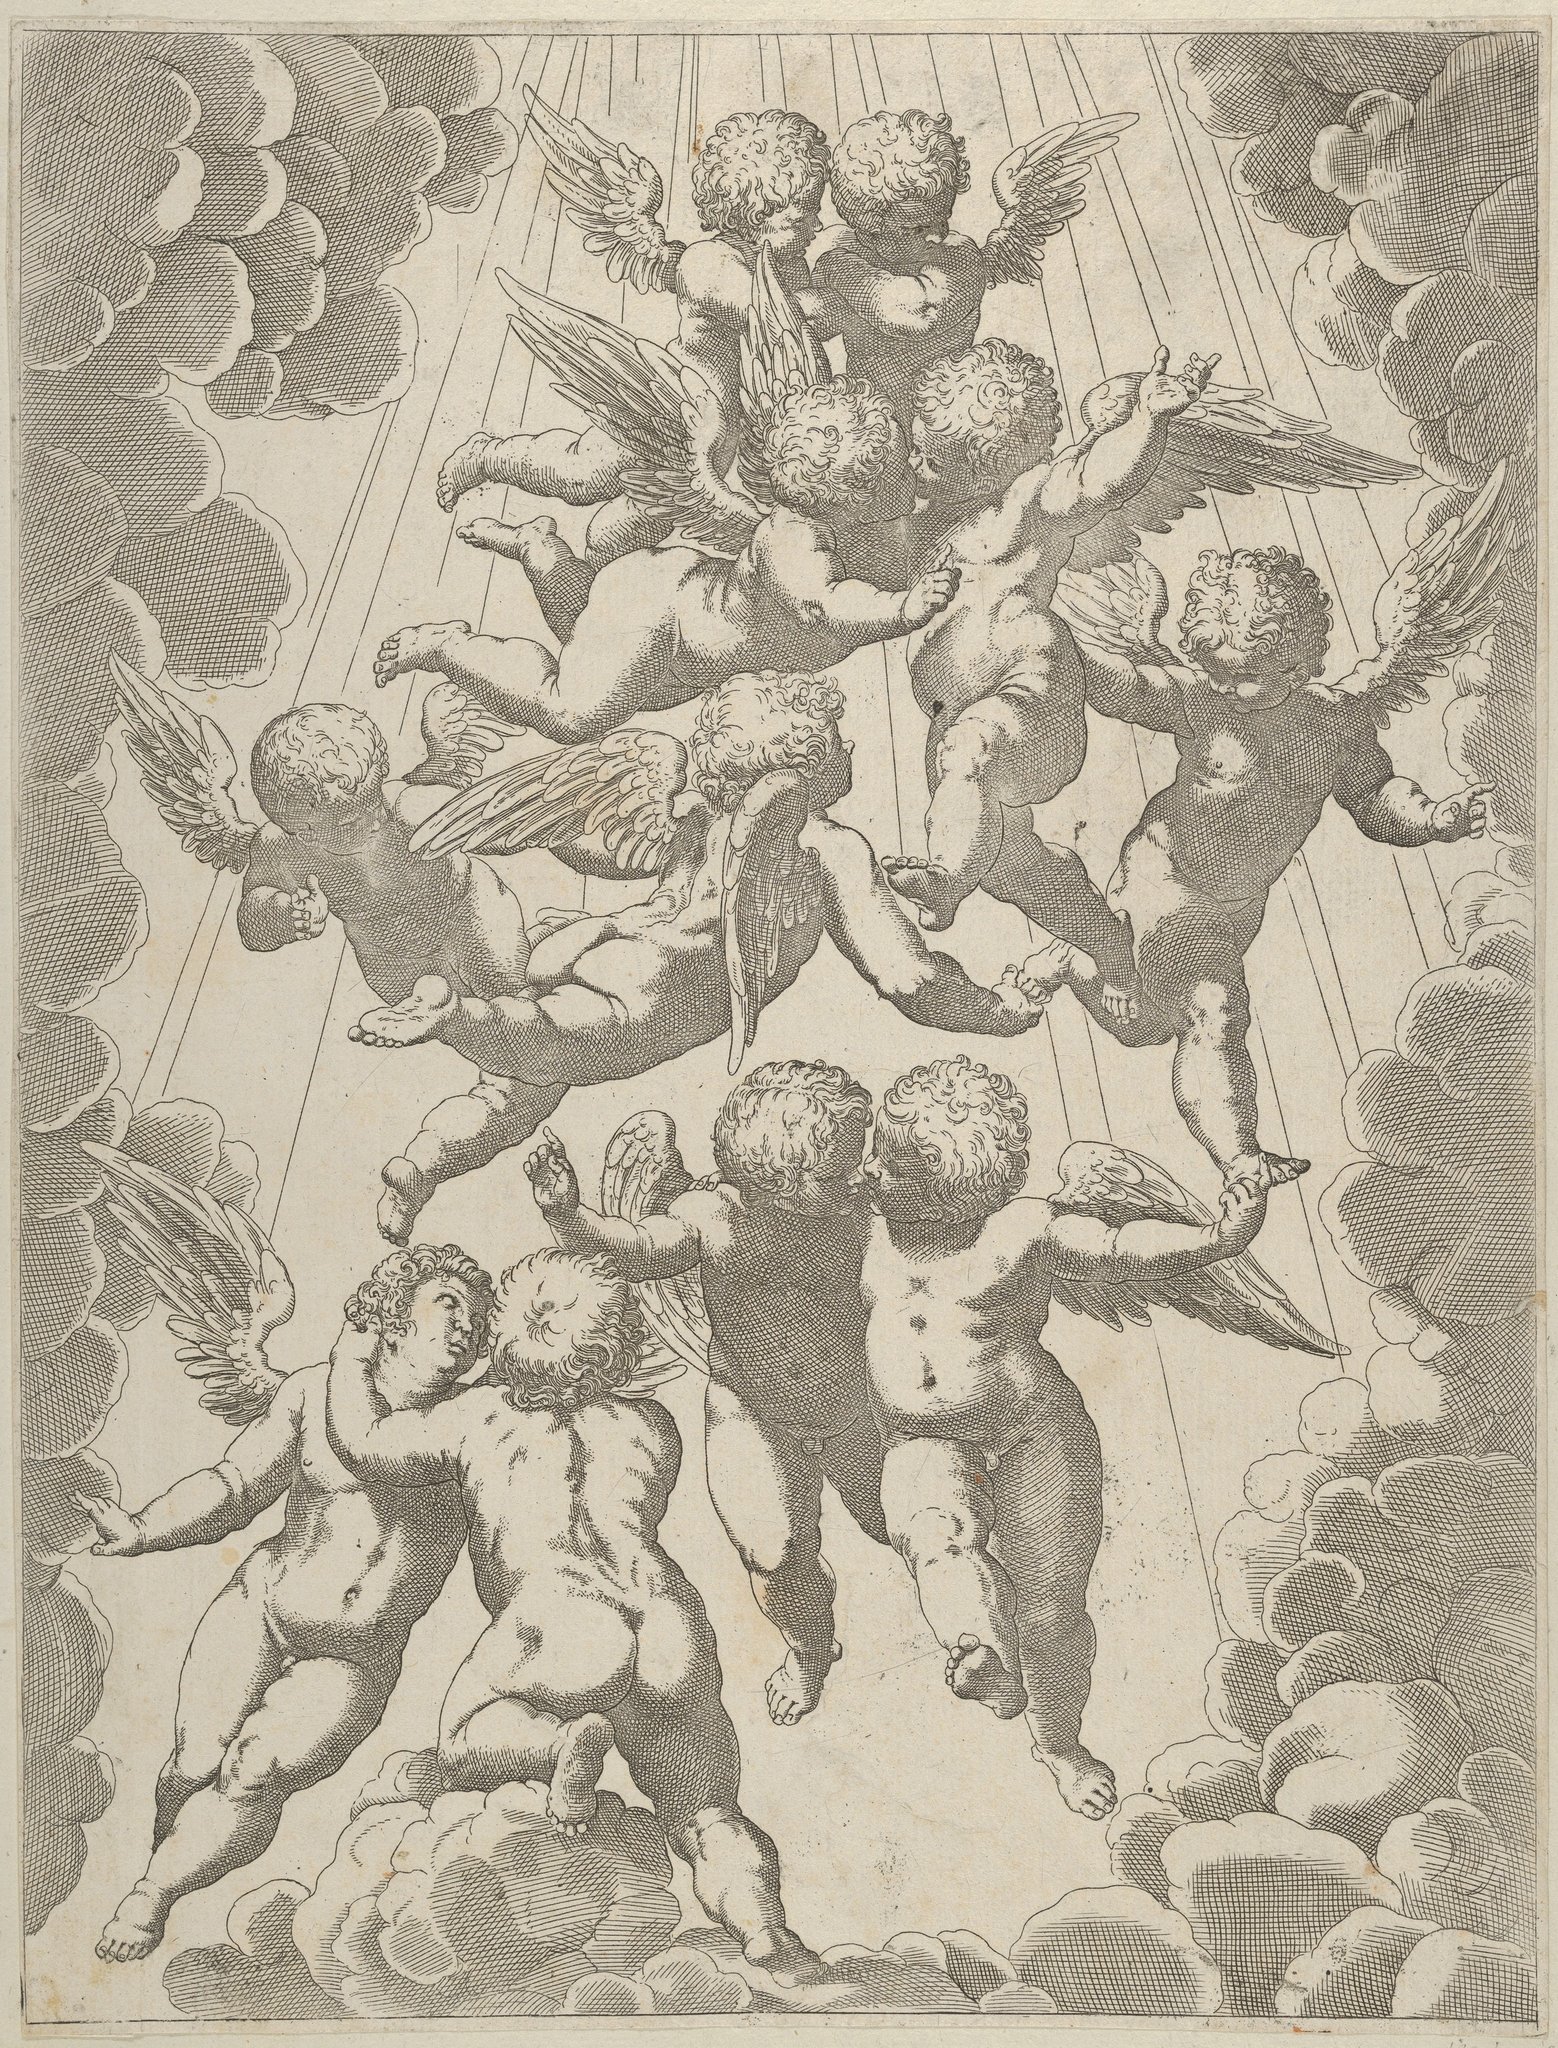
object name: print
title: A group of angels embracing in flight, framed by clouds, after Reni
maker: anonymous, 17th century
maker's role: artist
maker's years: 1600-1700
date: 1600-1640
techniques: etching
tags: angels